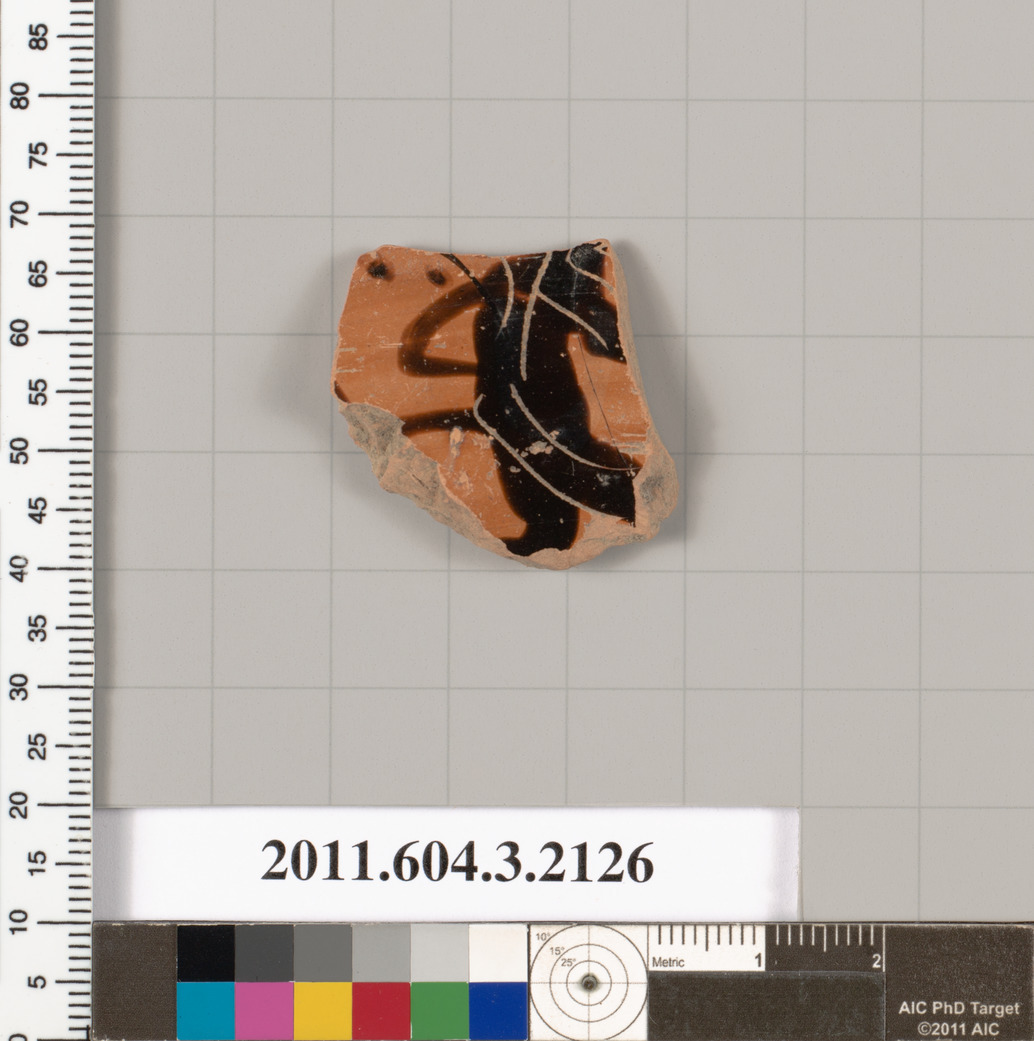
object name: kylix fragment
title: Terracotta rim fragment of a kylix (drinking cup)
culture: greek, attic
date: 500-480 BCE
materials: terracotta